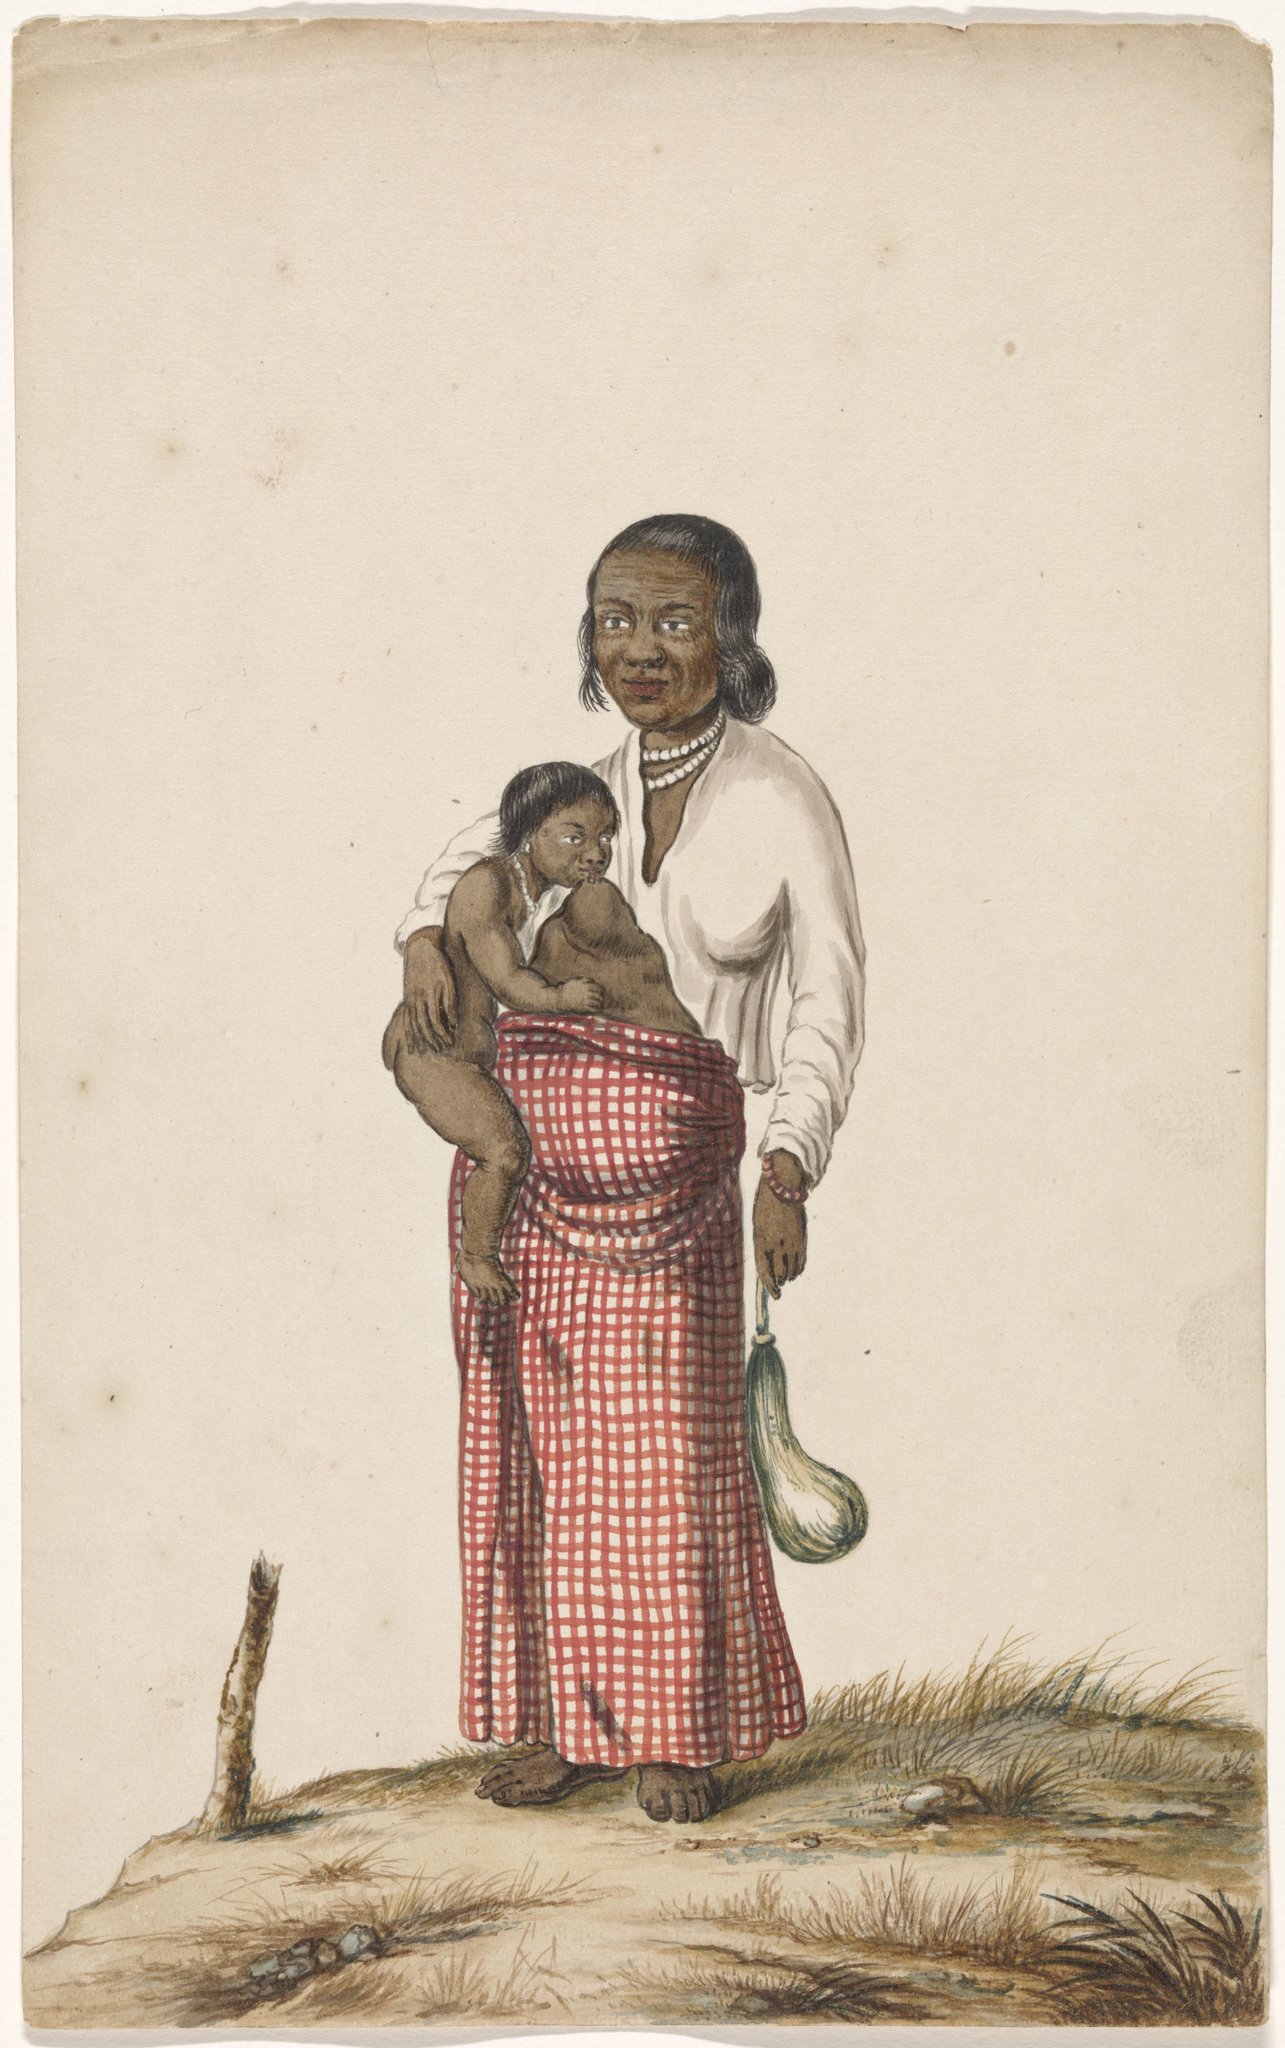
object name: drawing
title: A Malaysian Woman with an Infant and an Eggplant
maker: Anonymous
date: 1675-1725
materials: paper, watercolor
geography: netherlands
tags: asiatic races and peoples, dutch east indies, the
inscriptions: annotation: ‘Een Maleitse Vrouw’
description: Een vrouw met een kind aan haar borst. Het kind is naakt, de vrouw is kleed in een rood/wit geruite sarong en een wit jasje. In haar linkerhand draagt ze een aubergine.